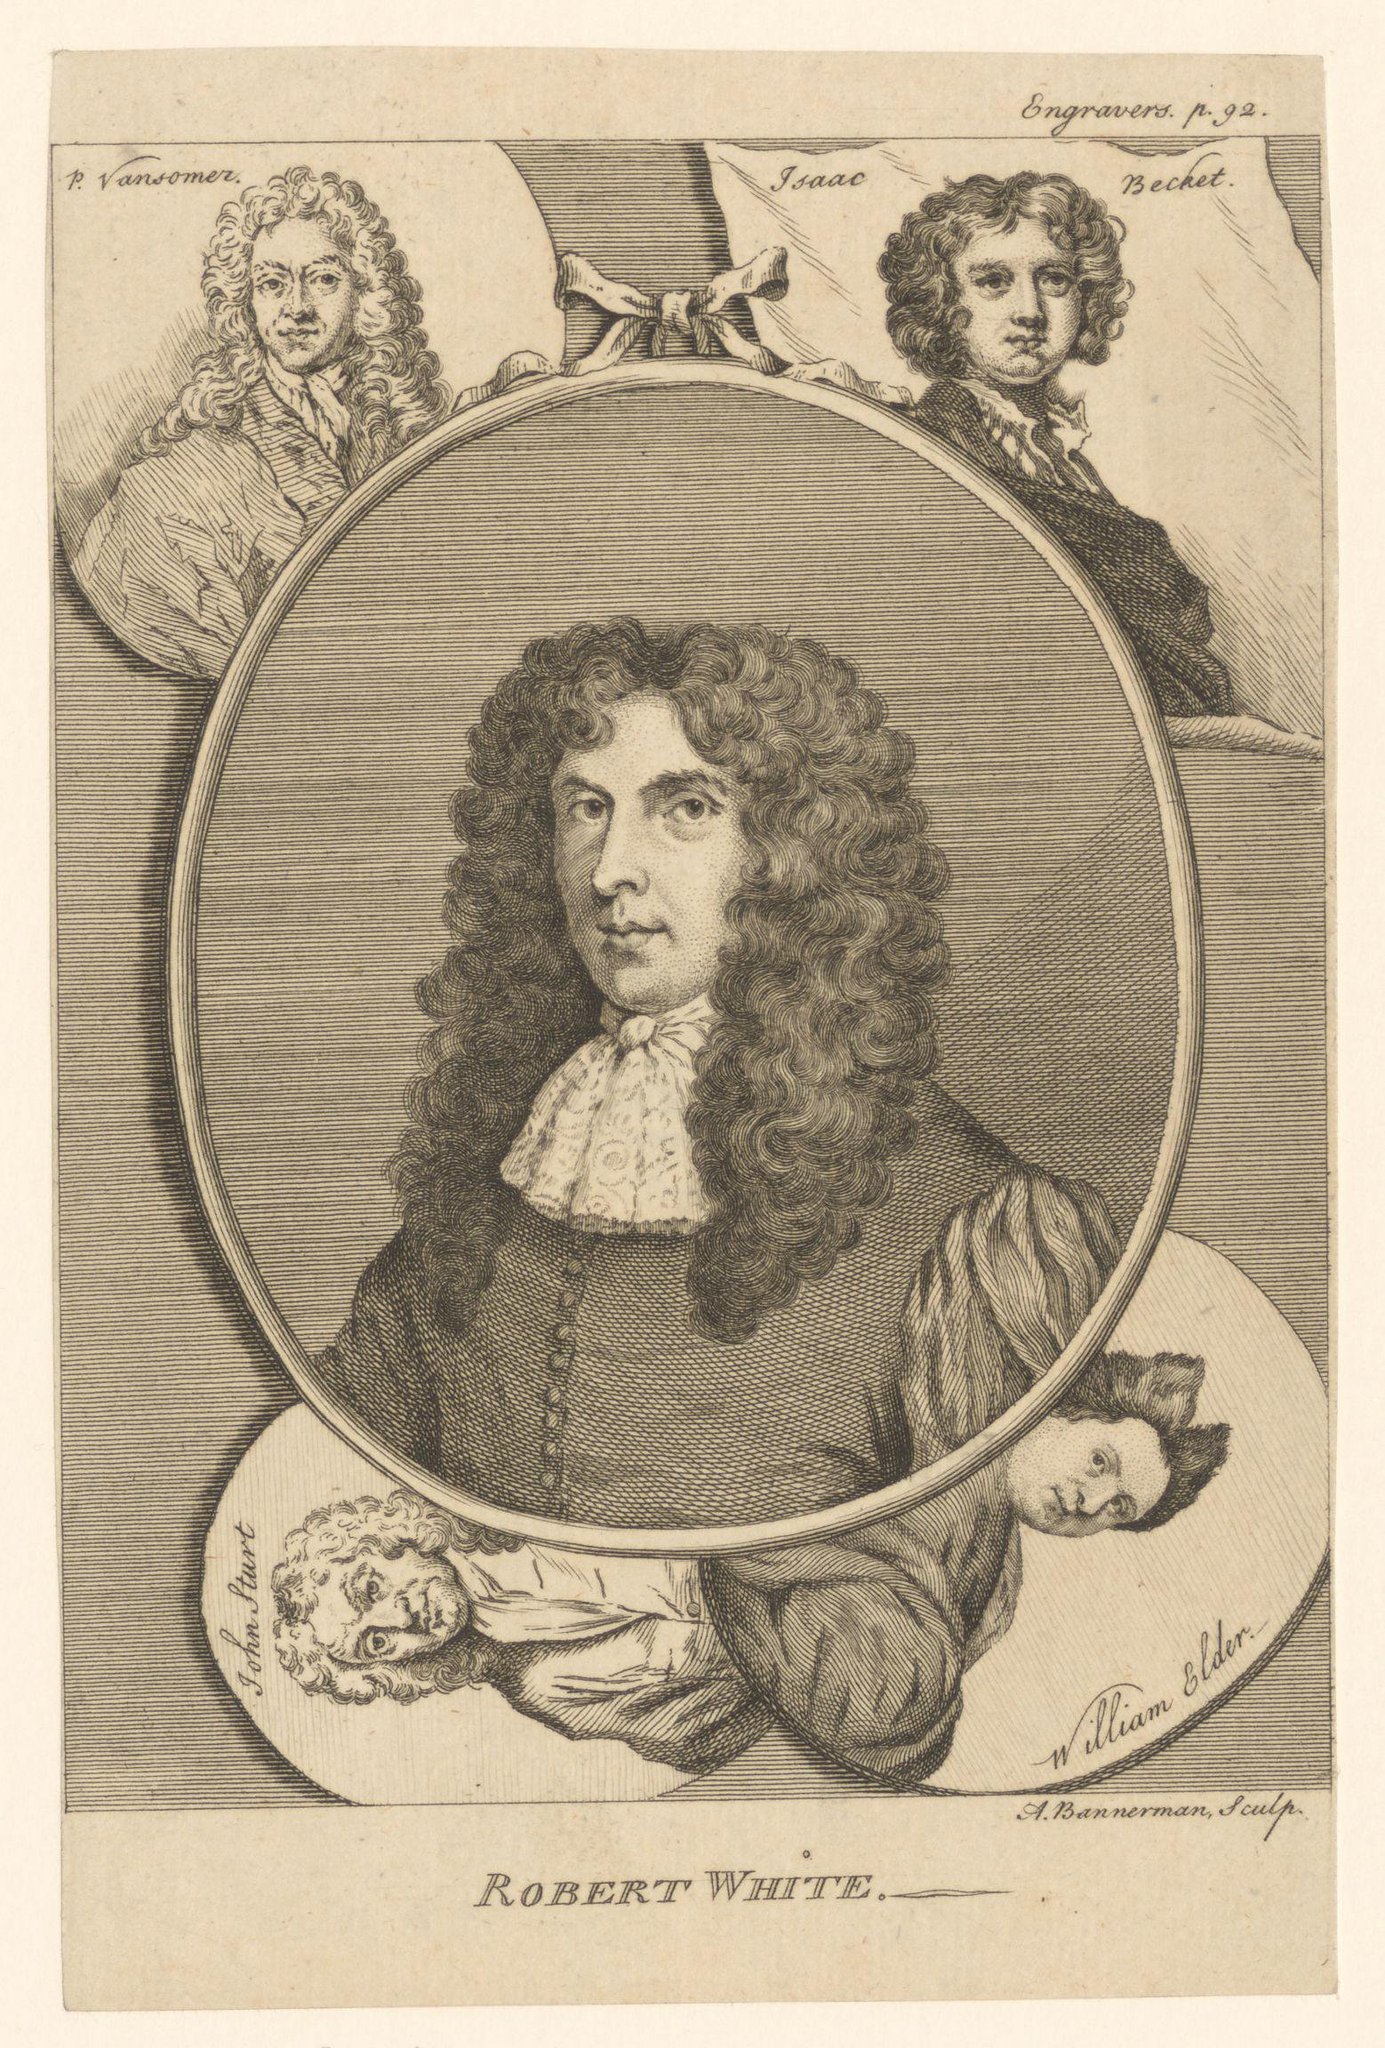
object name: book illustration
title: Portret van Robert White met vier kleinere portretten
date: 1765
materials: paper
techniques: engraving, etching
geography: england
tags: william elder, john sturt, london, print maker, robert white, isaac beckett, amsterdam, draughtsman, publisher, paul van somer (ii), historical persons, portrait, self-portrait of graphic artist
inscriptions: collector's mark: Lugt 2228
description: Prent uit: Vertue, George. A catalogue of engravers (...). Strawberry Hill: Horace Walpole, 1765, p. 92.